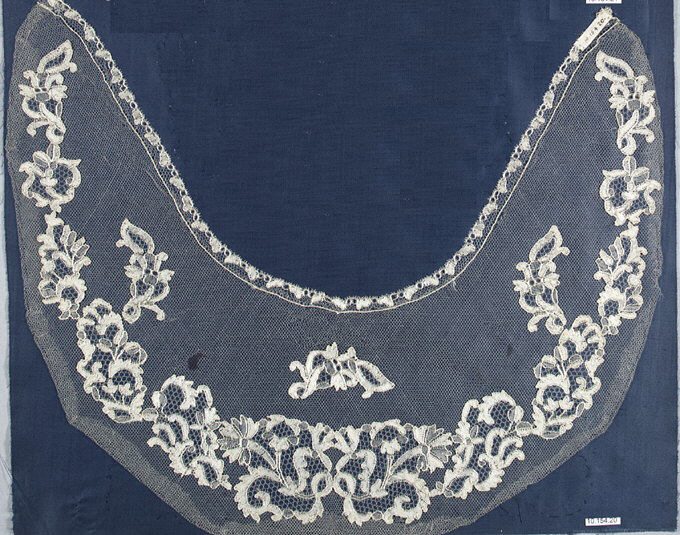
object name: collar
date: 1801-1900